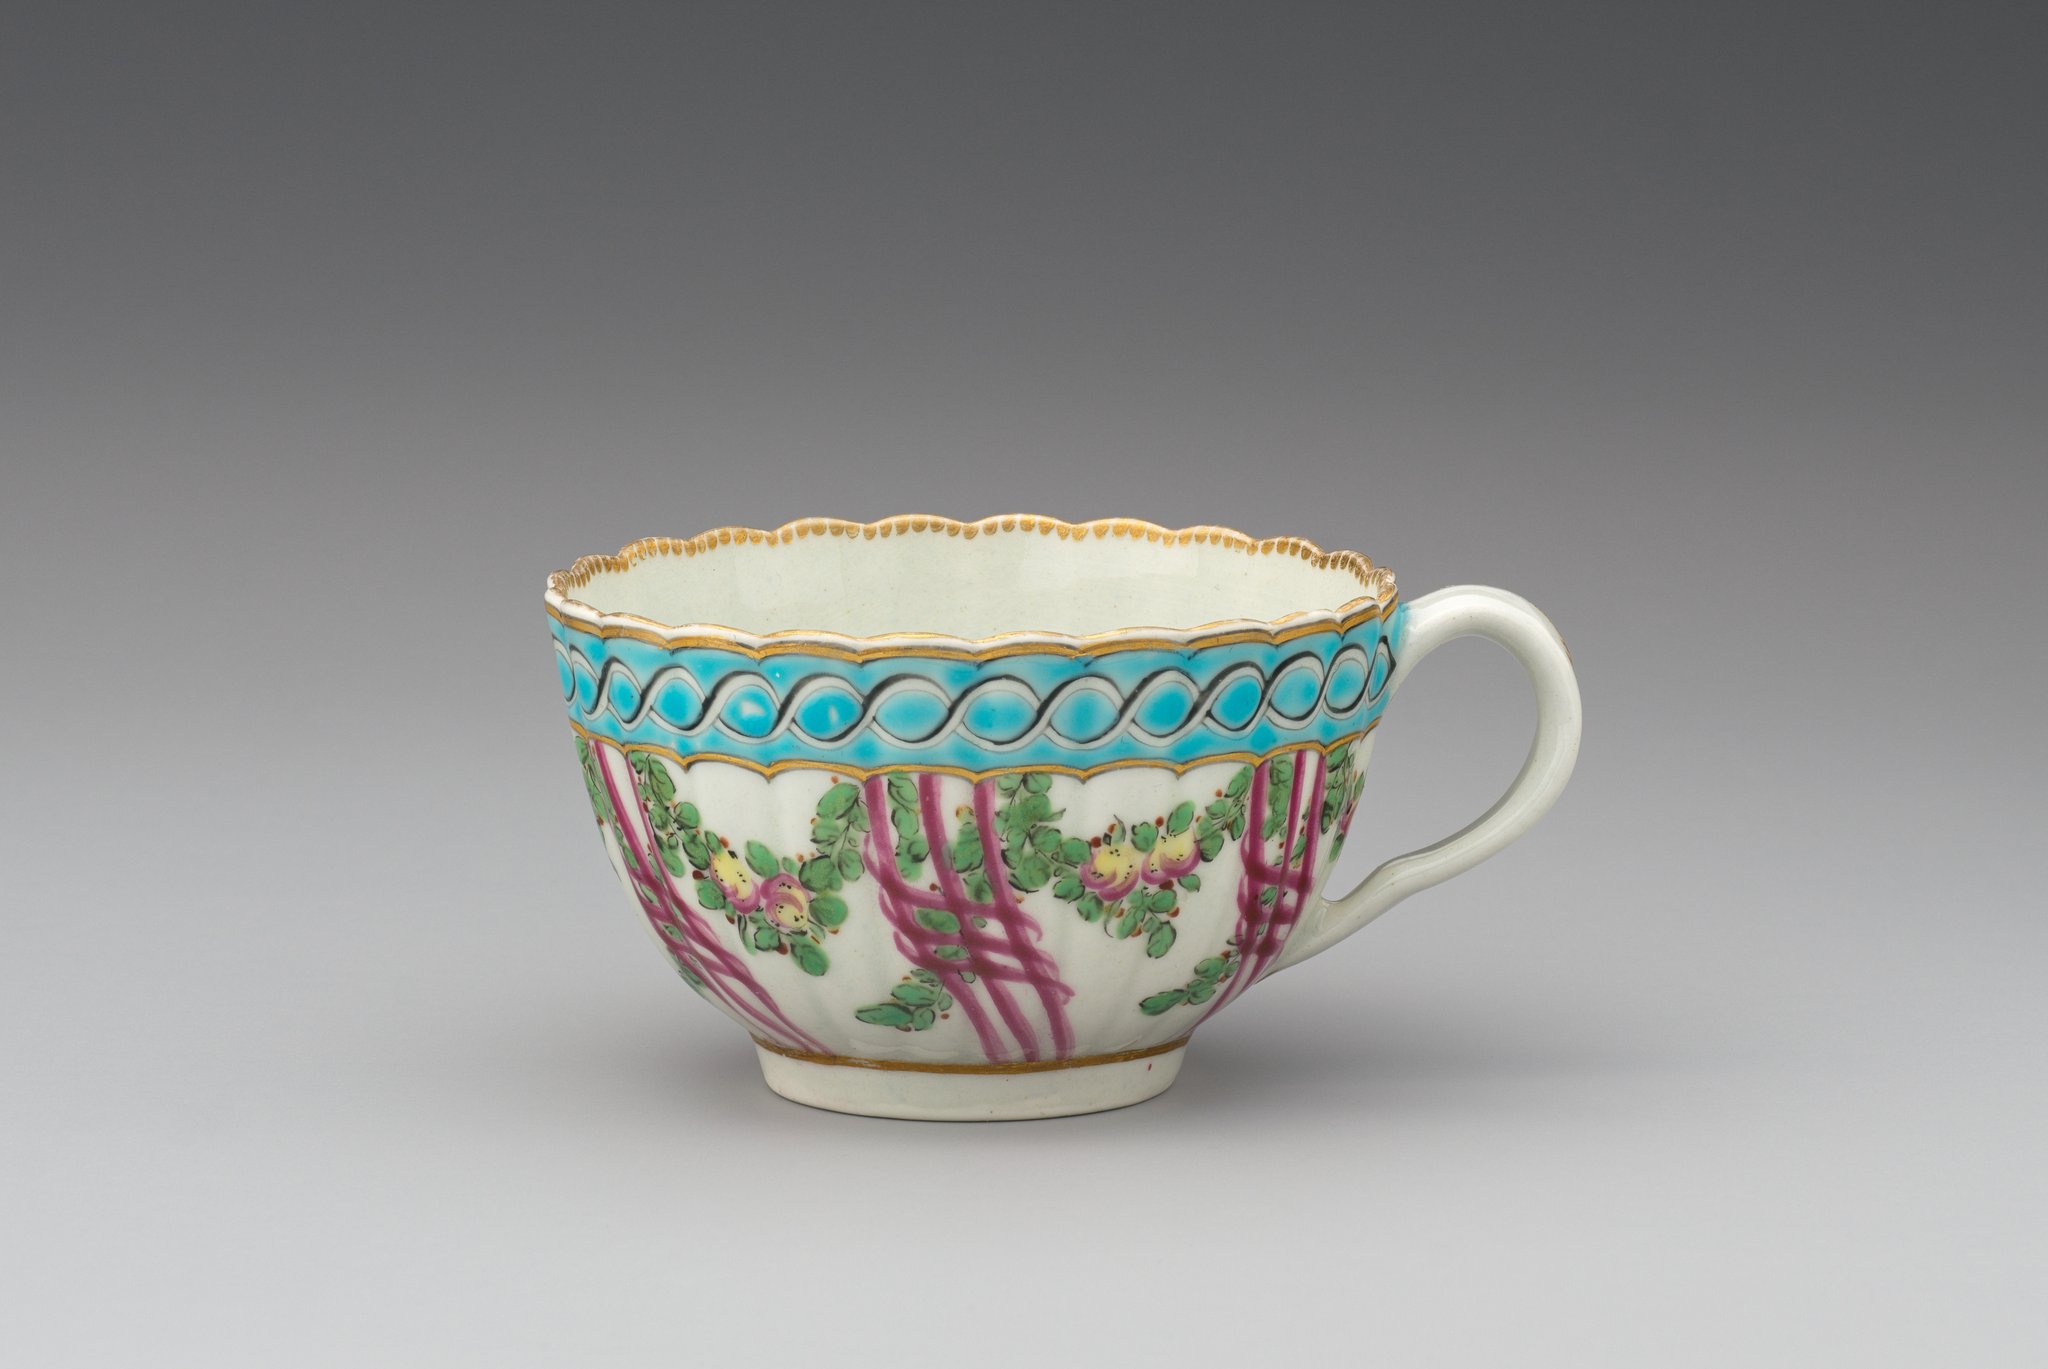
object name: teacup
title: Six tea cups (part of a service)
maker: worcester factory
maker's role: factory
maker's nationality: british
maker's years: 1751-2008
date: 1770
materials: soft paste porcelain